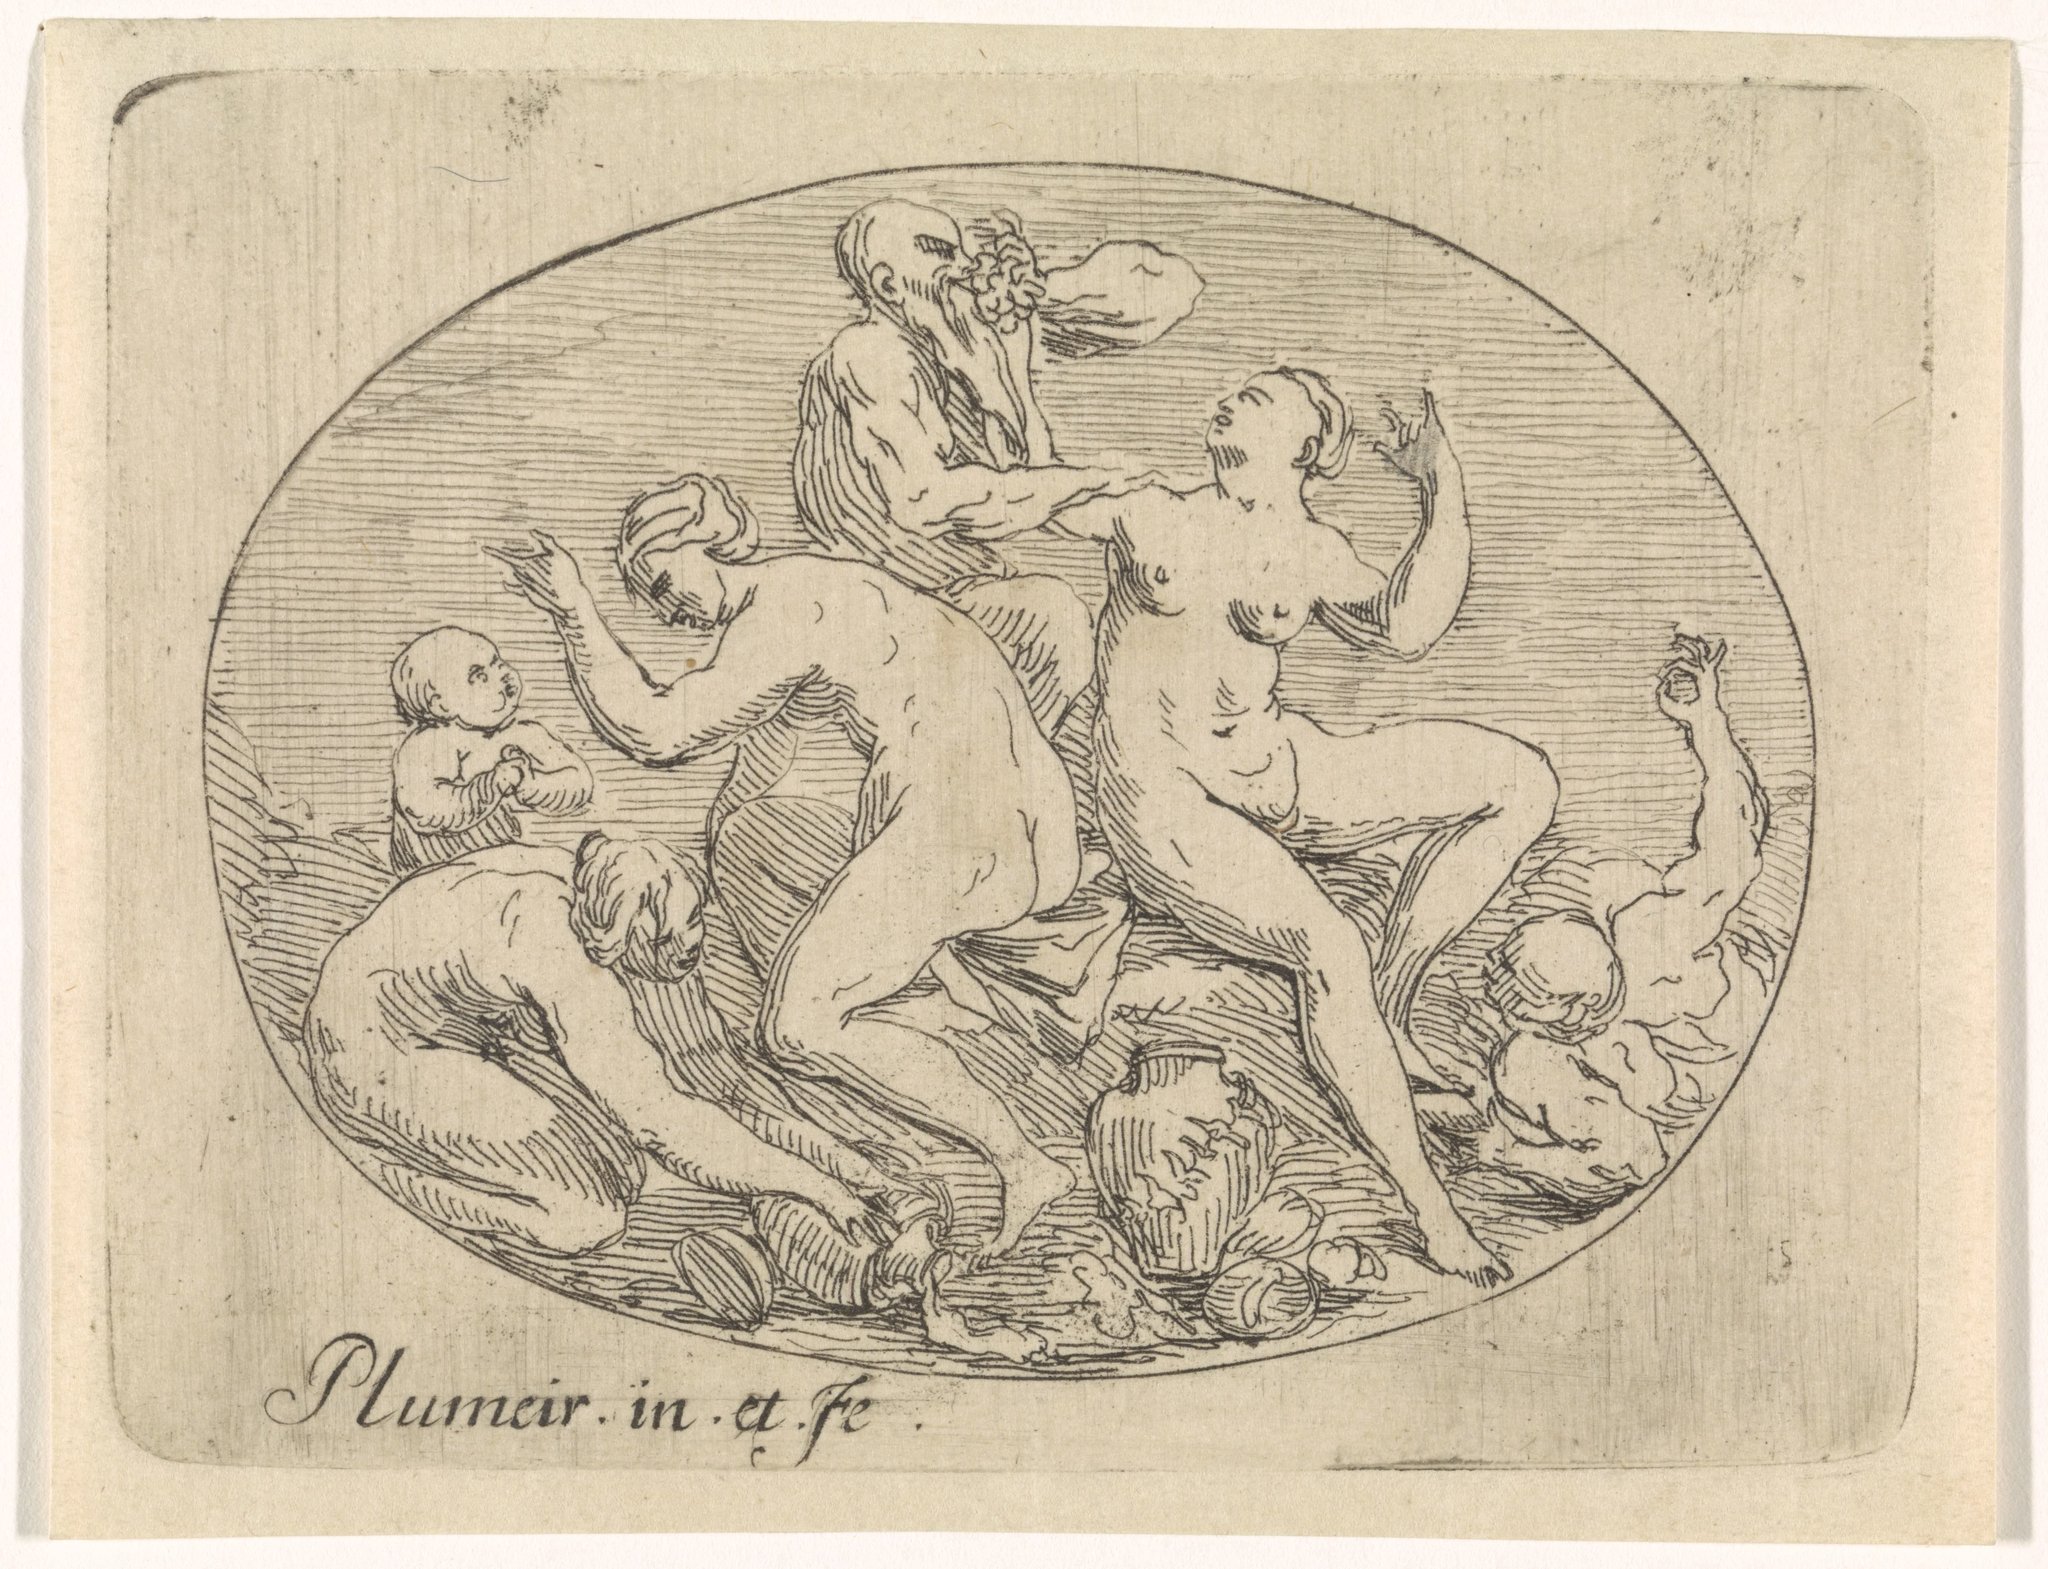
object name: print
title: Bacchanaal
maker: pierre denis plumier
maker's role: print maker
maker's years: 1688-1721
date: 1700-1721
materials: paper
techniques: etching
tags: maenad(s), female bacchant(es)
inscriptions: collector's mark: Lugt 240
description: Silenus zit te midden van een groep naakte bacchanten. Hij eet van een tros druiven. Op de grond enkele kruiken.